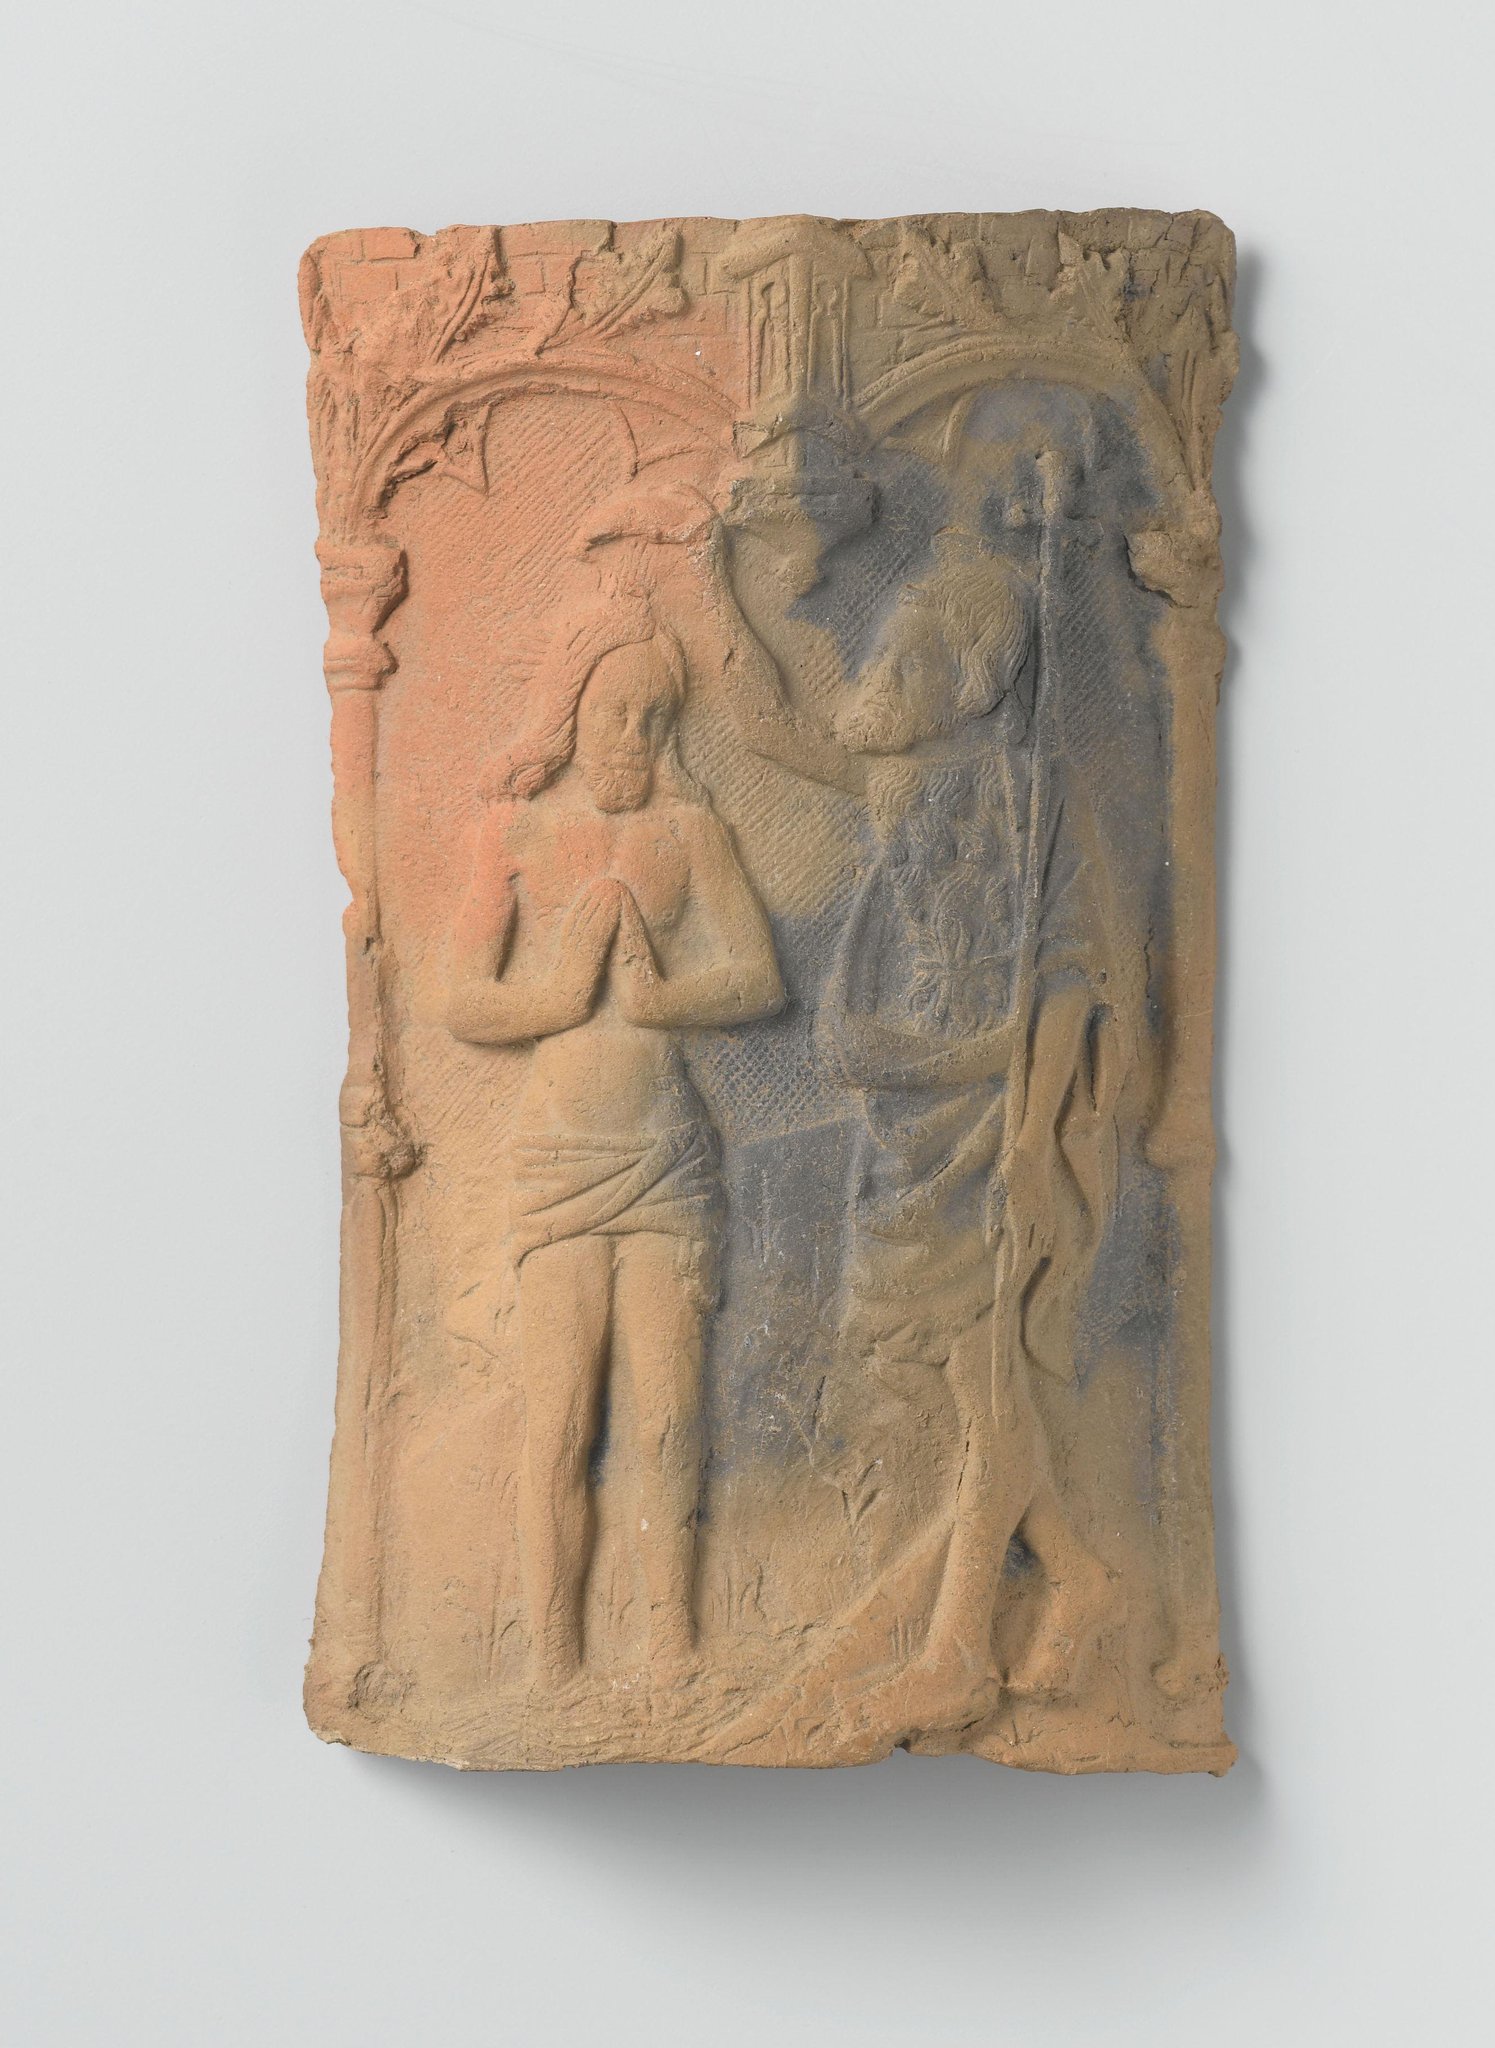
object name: cast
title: Baptism of Christ in the River Jordan (Patacon?)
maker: Anonymous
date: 1540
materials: terracotta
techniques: firing, forming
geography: leiden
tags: baptism of christ in the river jordan: john the baptist pouring out water on christ's head: the holy ghost descends, leiden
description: In the Middle Ages many cheap, simple religious items were produced, such as this terracotta pax. The mould was created directly from the costly ivory pax adjacent. While the scene of the baptism of Christ is an exact copy, the heraldic shield is omitted. This group of three objects shows how luxury works of art inspired cheap serial products.